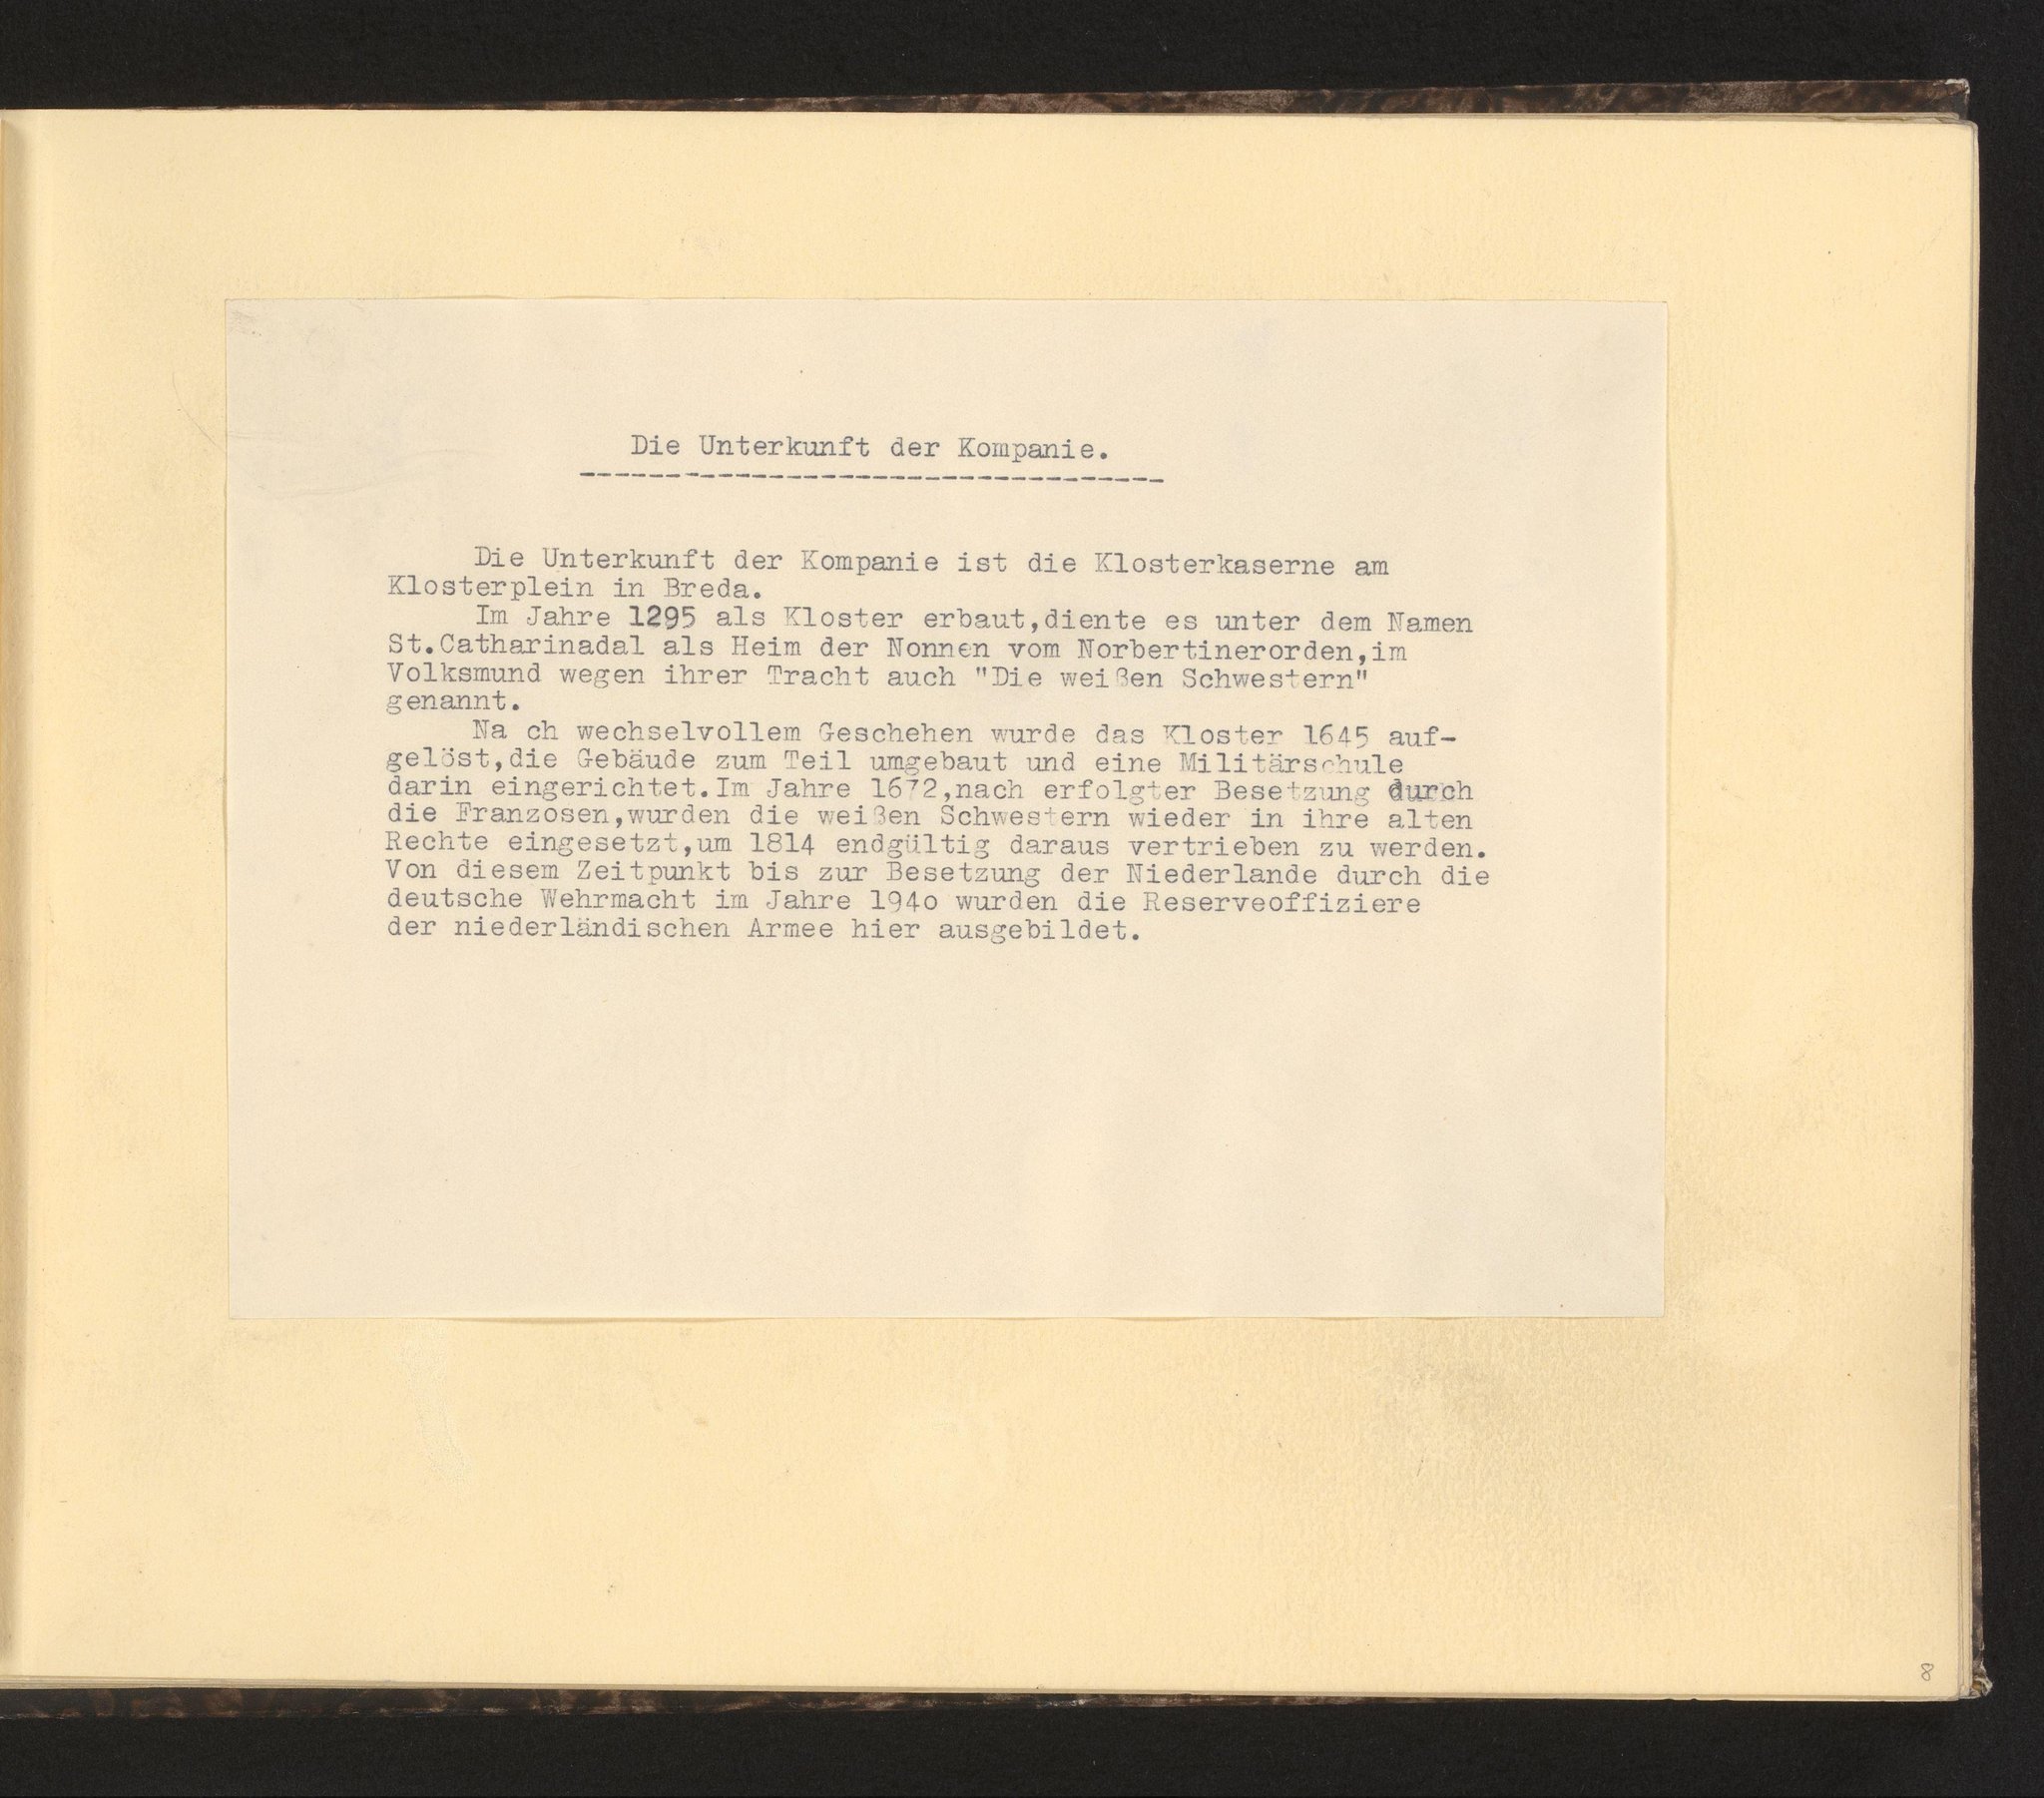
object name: text sheet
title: Die Unterkunft der Kompanie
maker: Anonymous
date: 1942-1943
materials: cardboard, paper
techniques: printing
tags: barracks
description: Albumblad met stencil met informatie over het onderkomen van de compagnie, de Kloosterkazerne te Breda (op de foto's op het volgende blad). Onderdeel van het fotoalbum van de Luftnachrichten-Regiment 211,1942-1943.